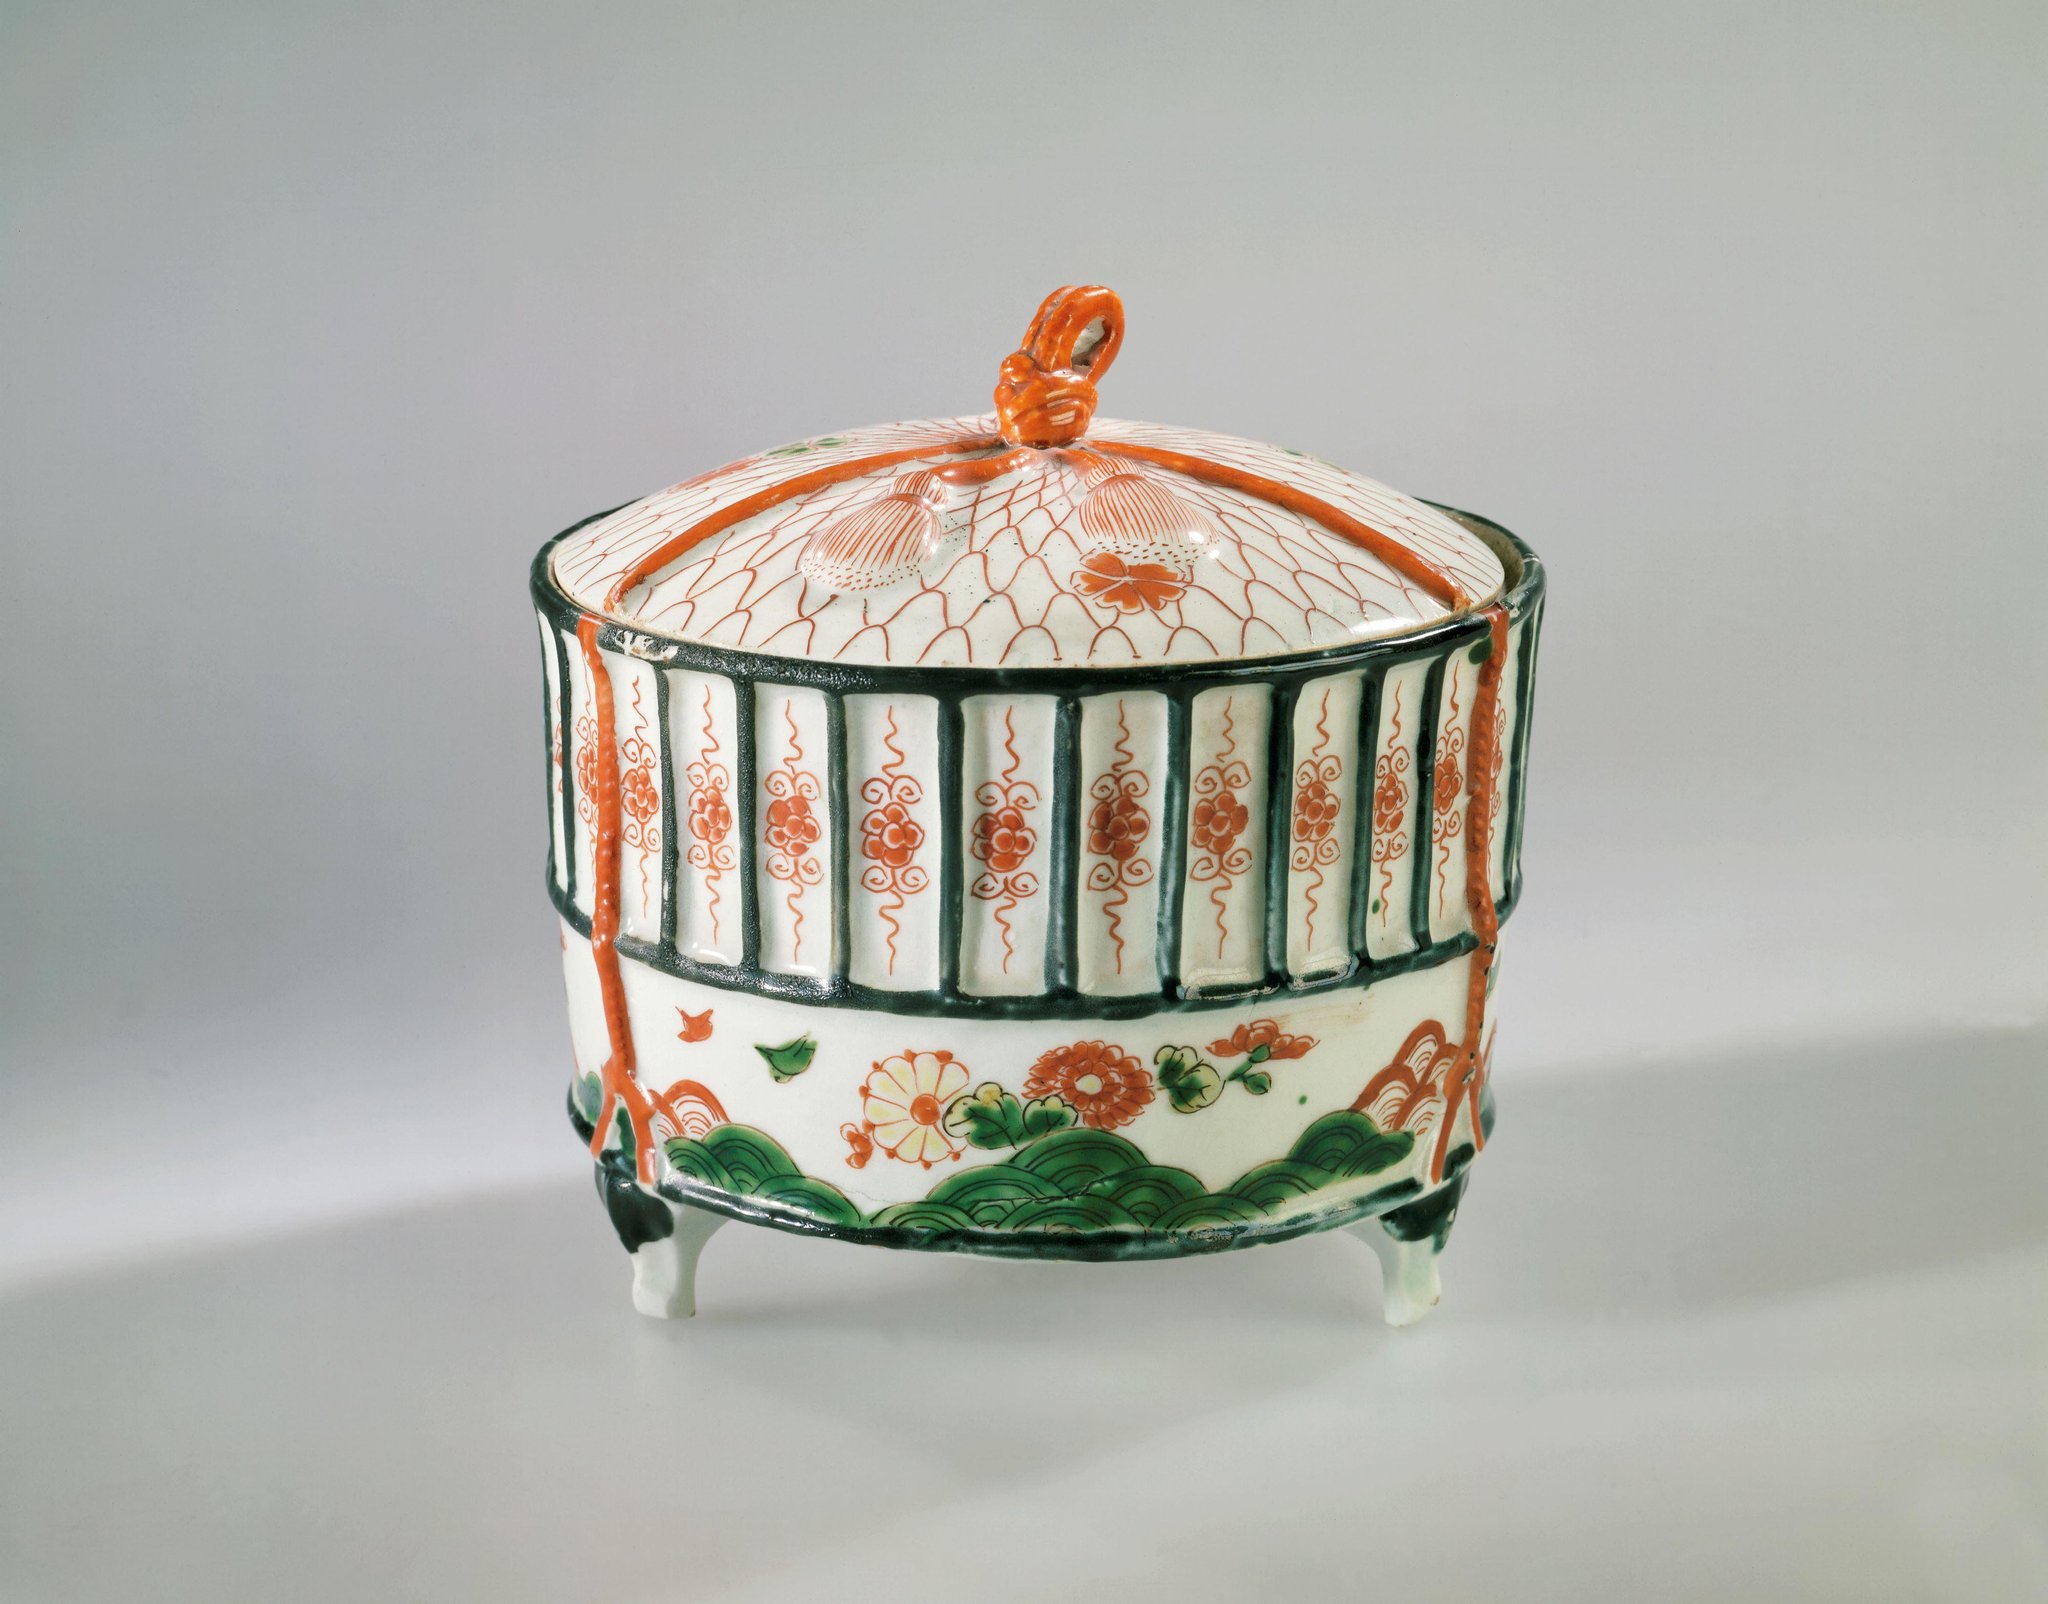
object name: box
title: Cilidrical covered box in the shape of a cricket's cage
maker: Anonymous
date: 1675-1699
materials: cobalt, glaze, paint, porcelain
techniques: firing, forming, turning, vitrification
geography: japan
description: Dekselpot op drie poten, met rechte wand en licht gebolde deksel. Het bovenste deel van de wand imiteert de tralies van de kooi (in reliëf). De beschildering van het deksel imiteert een net dat met een koord vastgebonden is; de knood van het koord vormt de dekselknop. Beschilderd met gestileerde ranken en bloemtakken in onderglazuur blauw en rode en groene emailkeuren.